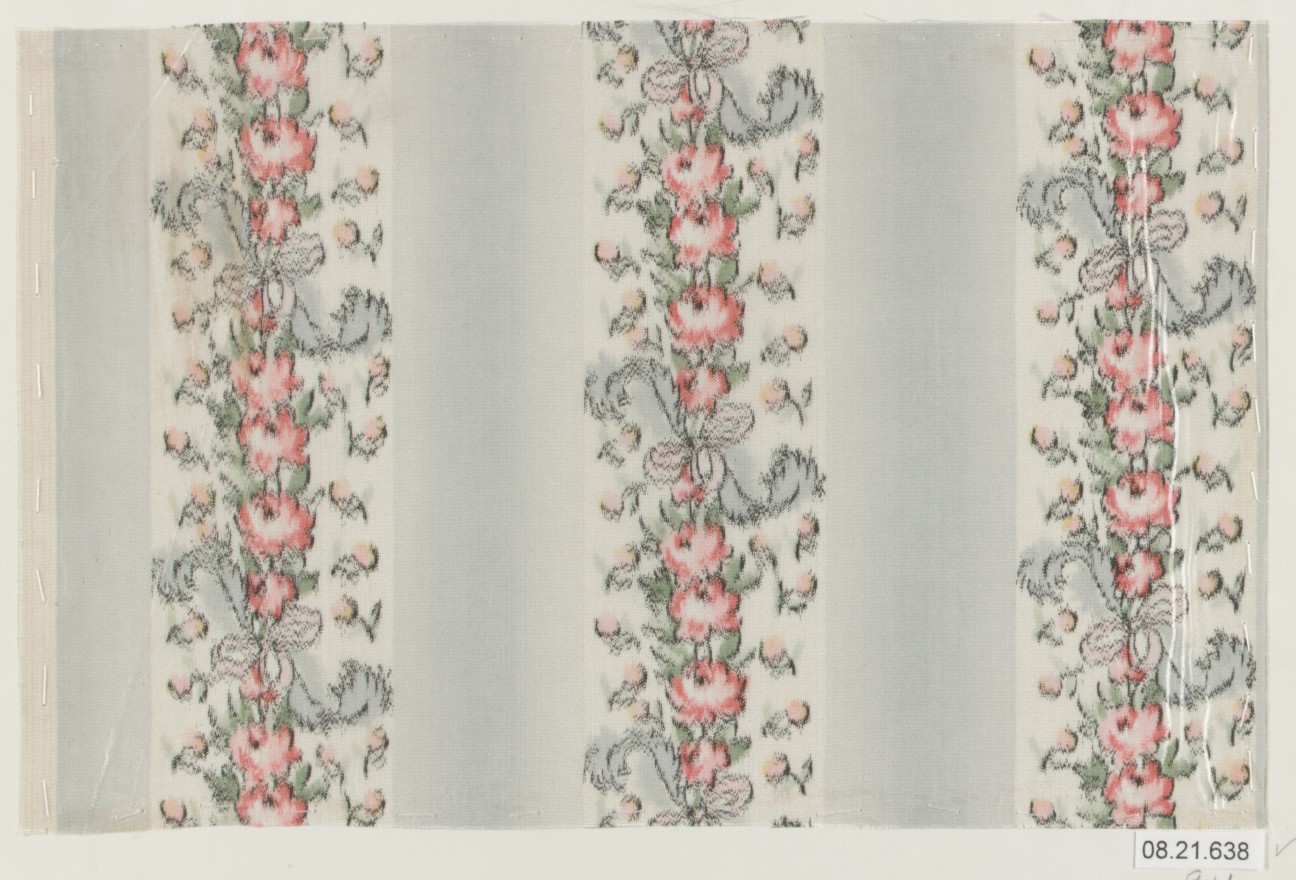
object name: textile sample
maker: Anonymous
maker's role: designer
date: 1900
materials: silk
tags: flowers